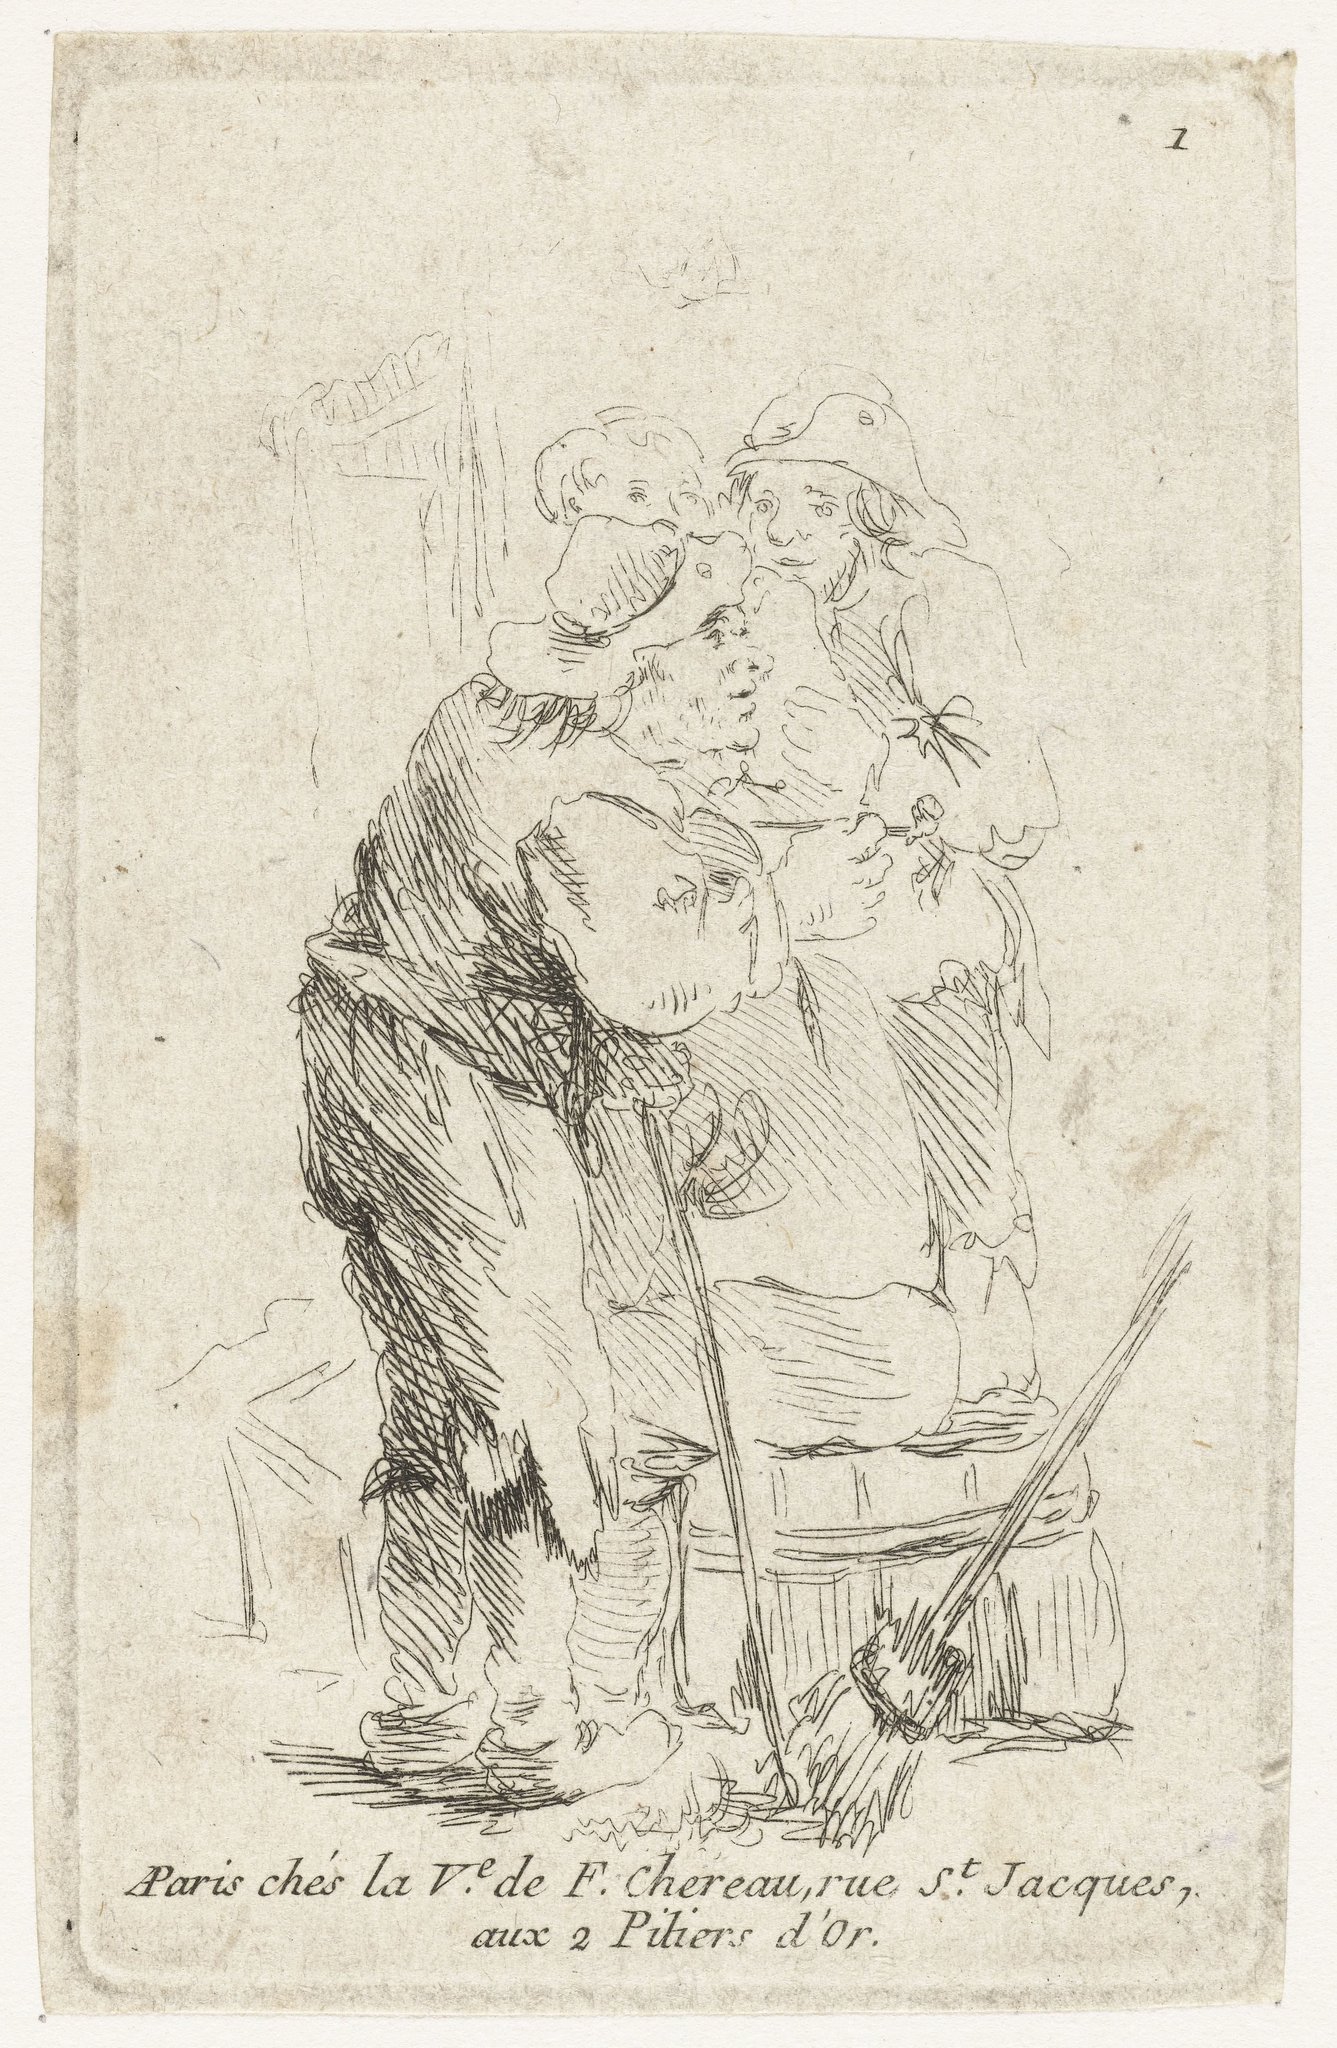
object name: print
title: Suite van kleine genrestukjes en koppen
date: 1727-1755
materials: paper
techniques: etching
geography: paris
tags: farmers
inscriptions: collector's mark: Lugt 2228, collector's mark: Lugt 2760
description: Een man leunend op een stok, met een pijp in de hand. Op een verhoging nog twee figuren.